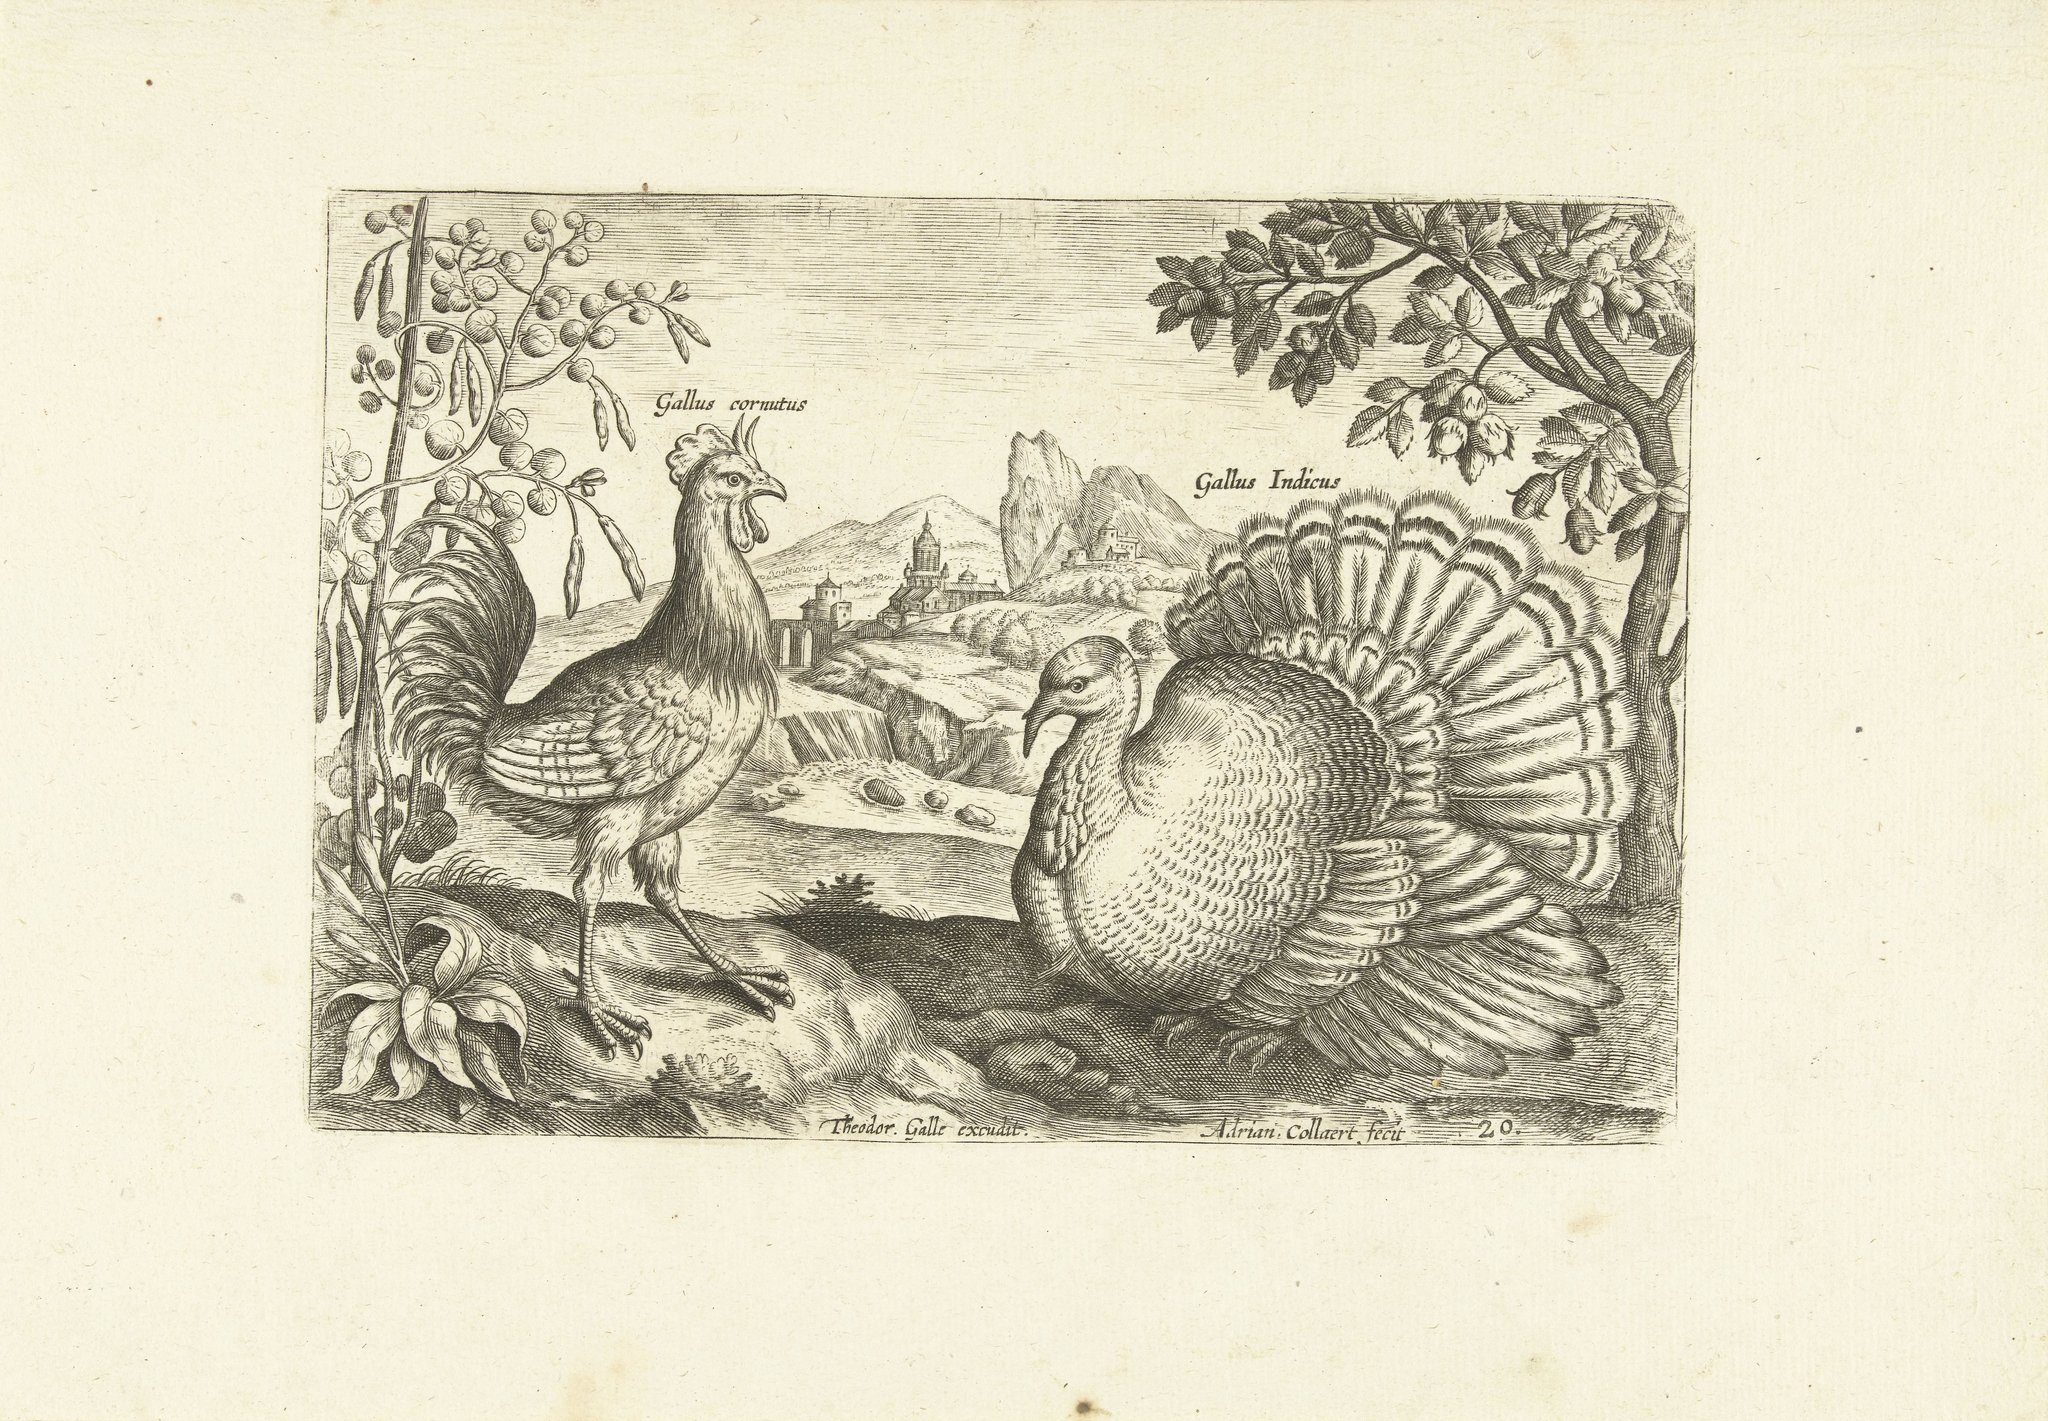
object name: print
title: Twee hoenderen in een landschap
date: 1598-1618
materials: paper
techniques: engraving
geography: antwerp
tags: waterfall, fowl (cock, hen, chicken, etc.), walker and runner birds: turkey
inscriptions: collector's mark: Lugt 2228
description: Een haan en een kalkoen in een landschap met een waterval. De prent maakt deel uit van een serie met vogels als onderwerp.